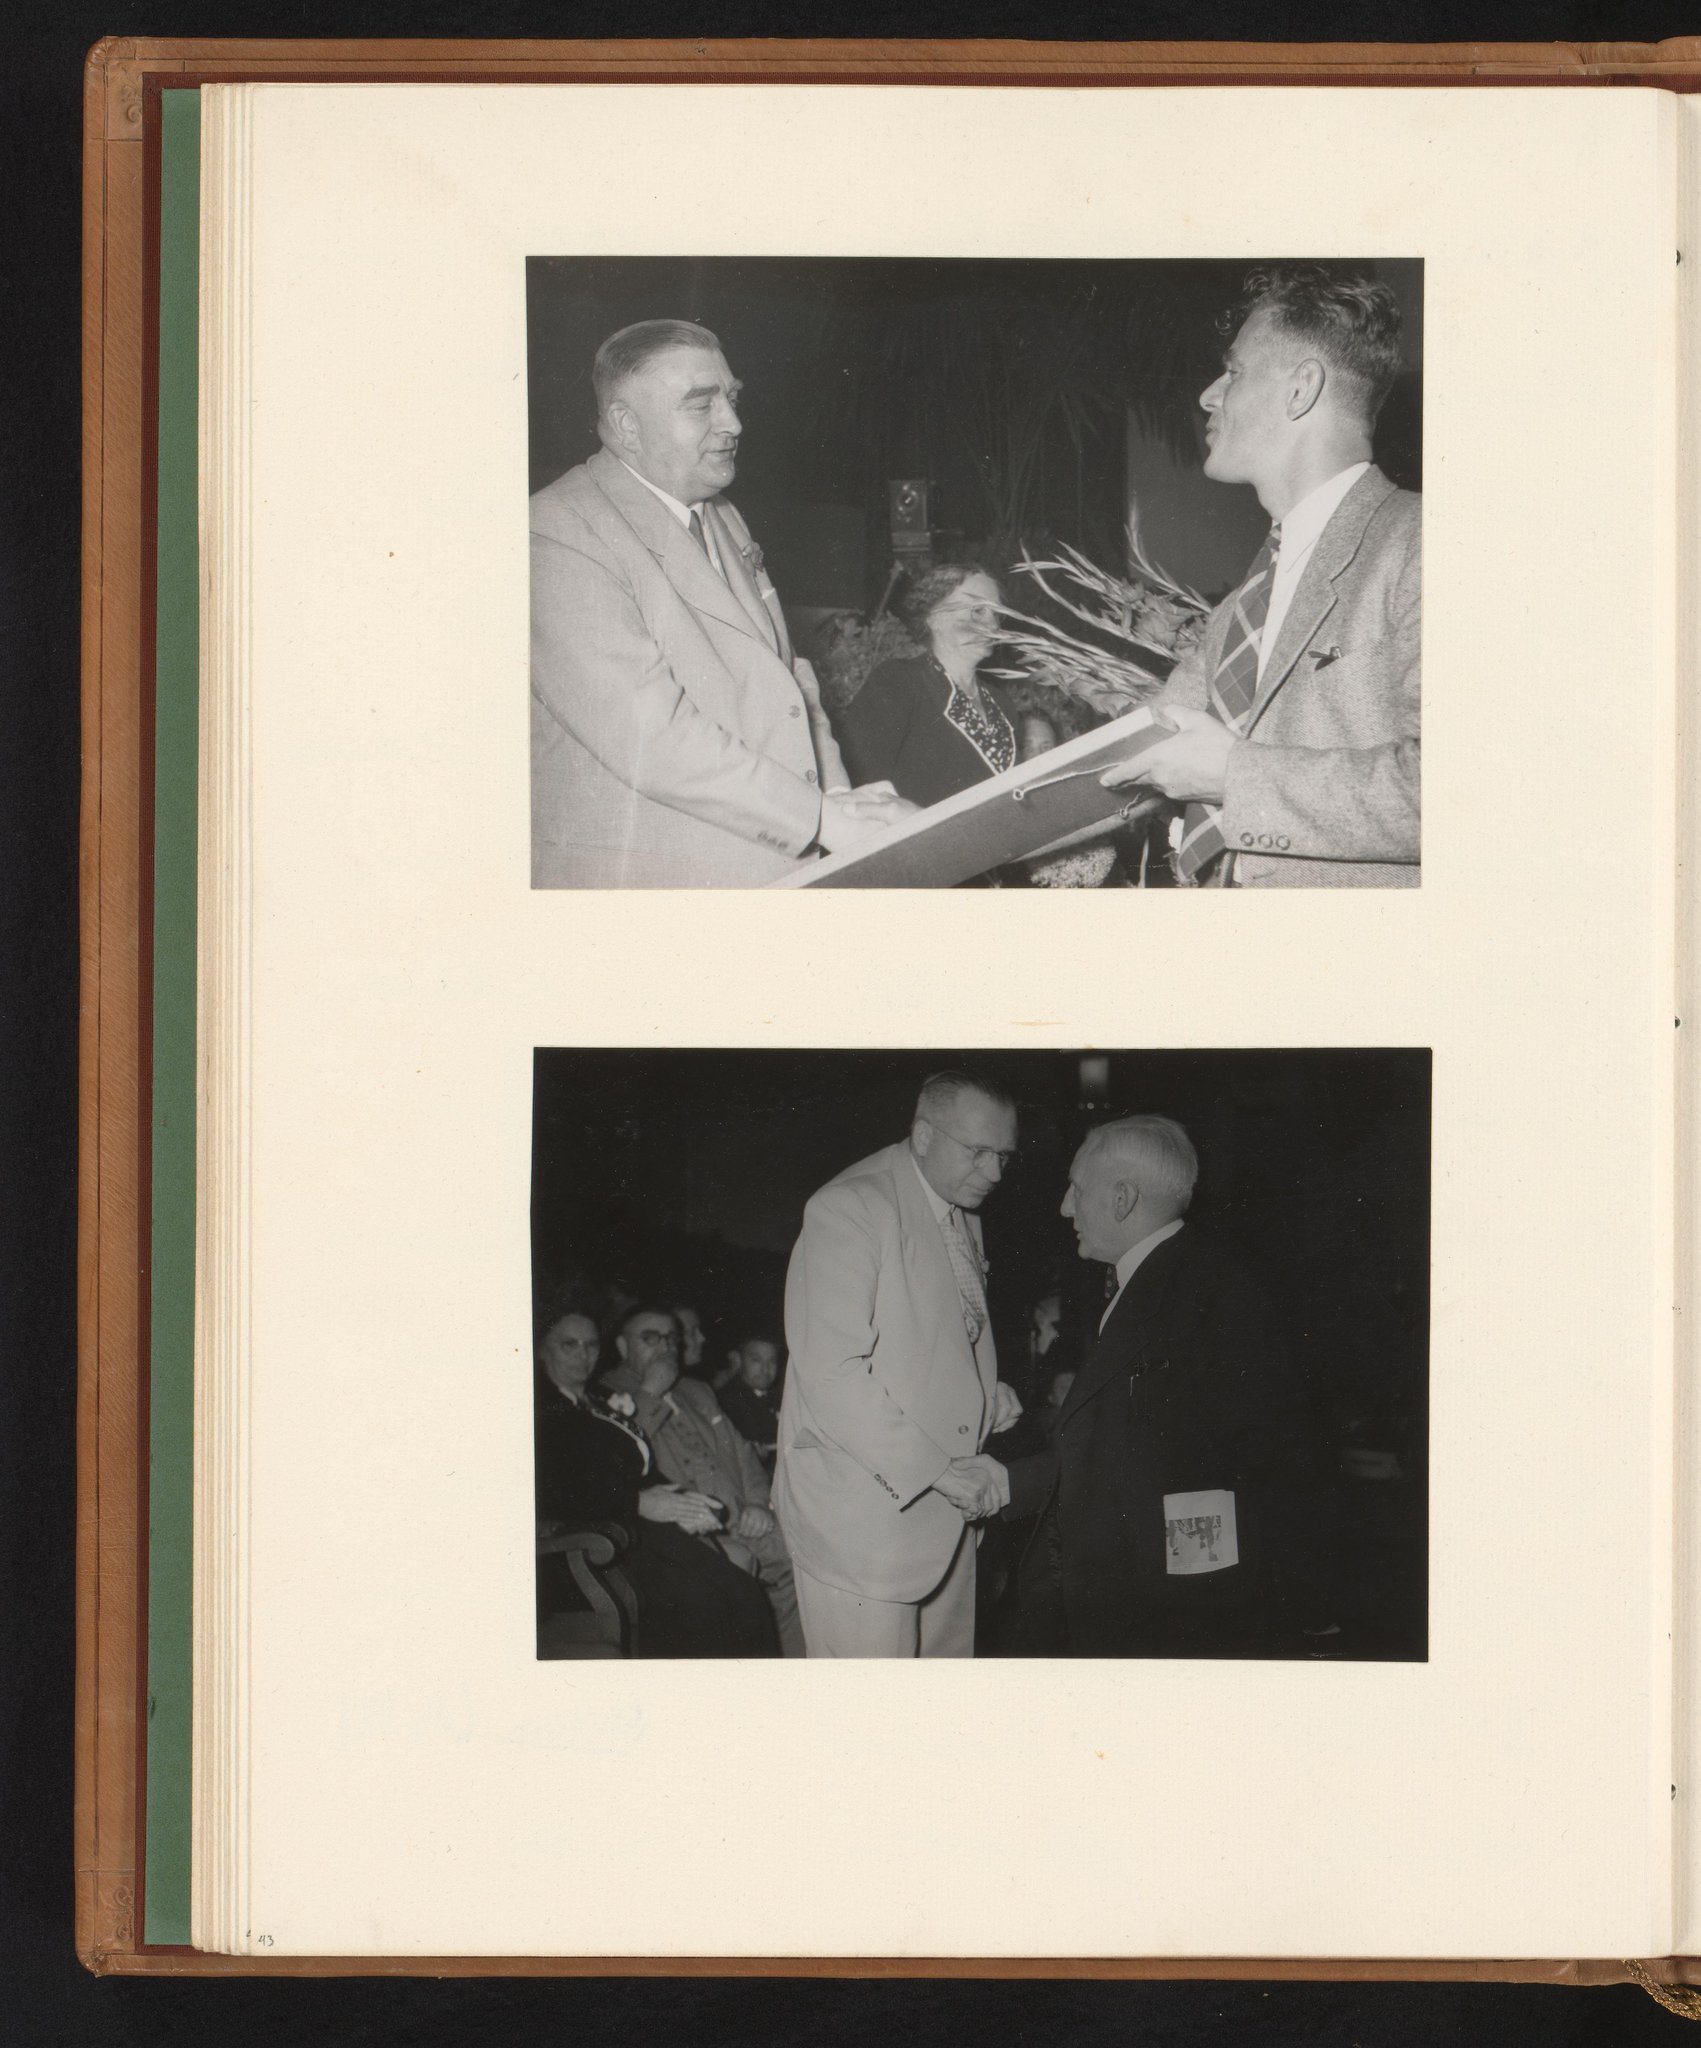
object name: photograph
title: Afscheid van Kupers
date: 1949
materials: paper, photographic support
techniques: gelatin silver print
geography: amsterdam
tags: shaking hands, 'dextrarum junctio', modern professional organization, trade union, reception, cocktail party, amsterdam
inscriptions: company name: ‘Fotodienst Het Vrije Volk / Hekelveld 15, Amsterdam’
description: Blad met twee foto's waarin een onbekende man handen schudt (boven) en Kupers handen schudt (onder). Onderdeel van het fotoalbum ter gelegenheid van het afscheid van Evert Kupers als voorzitter van de NVV op 14 juli 1949 in Amsterdam.